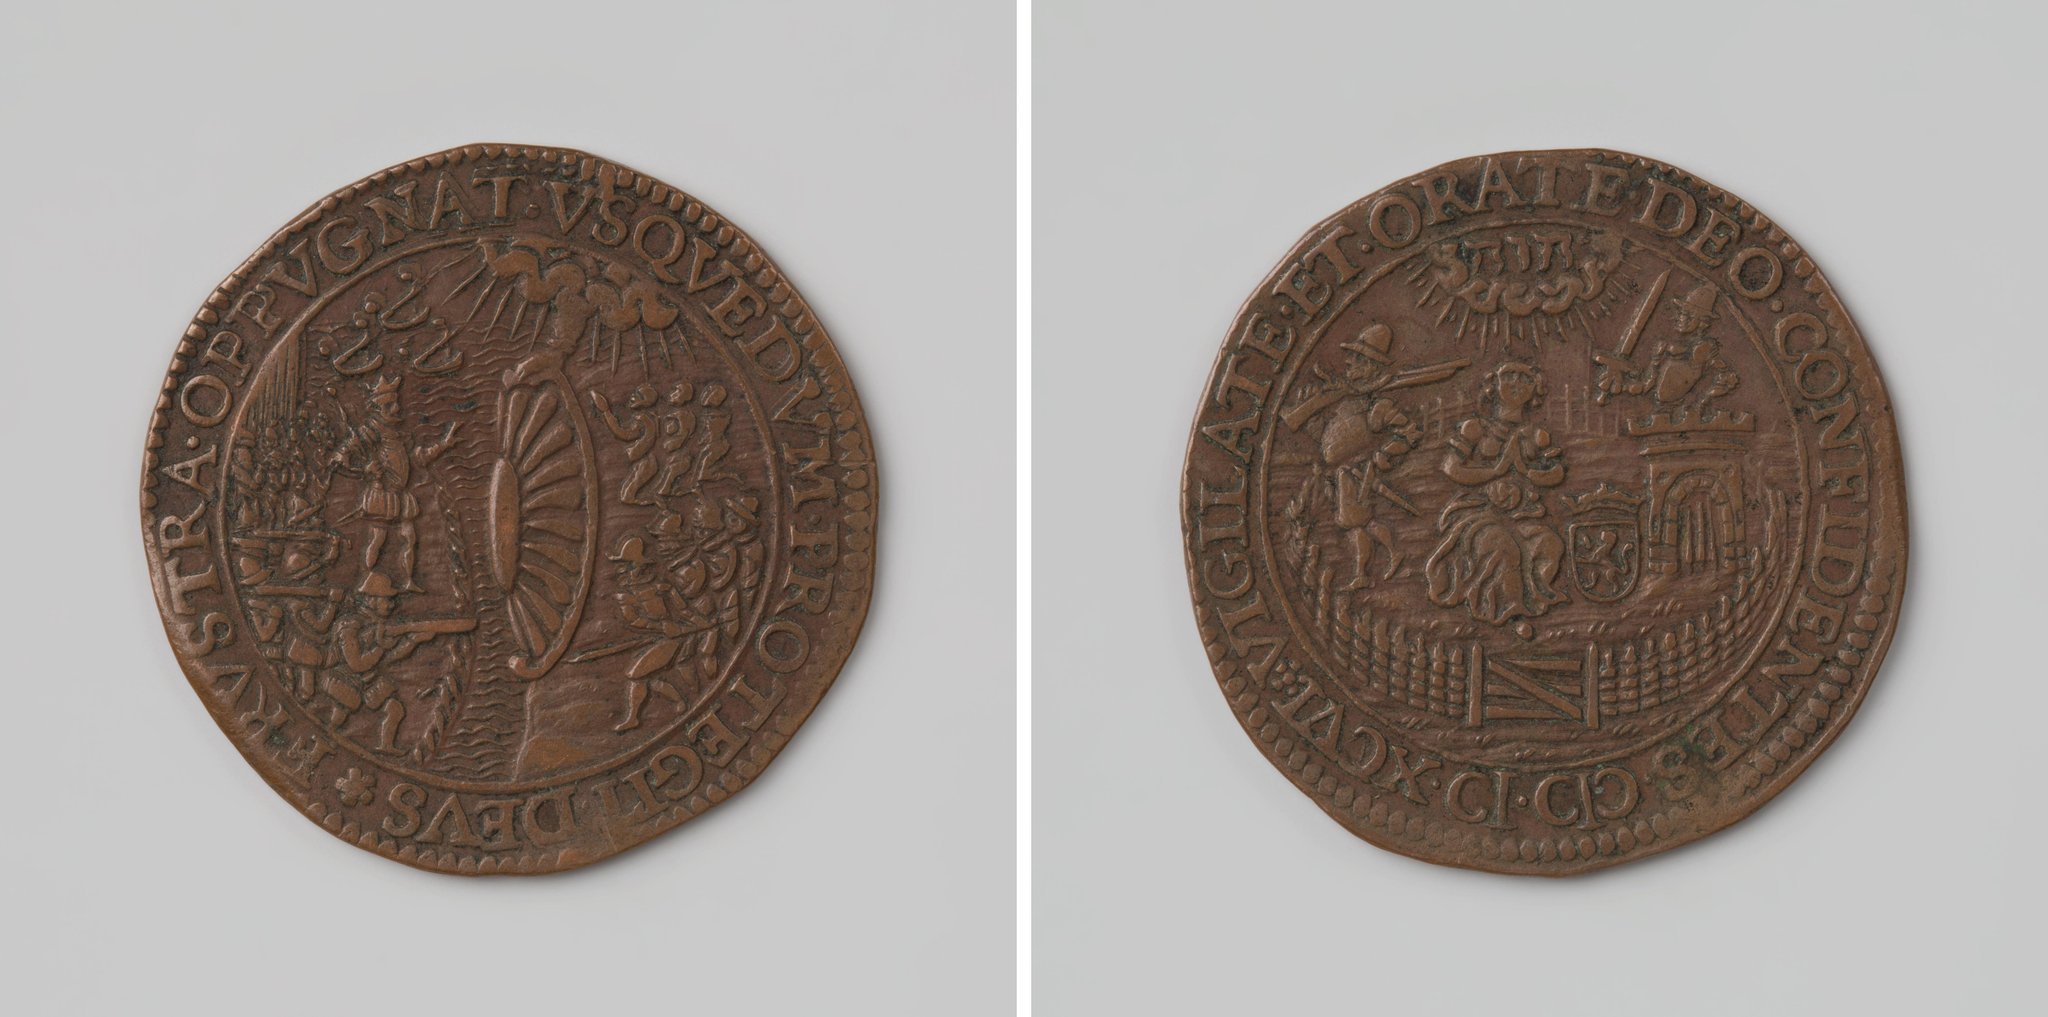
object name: jeton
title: Inval van Albrecht, aartshertog van Oostenrijk, in Zeeuws Vlaanderen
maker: Anonymous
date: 1596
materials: copper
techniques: striking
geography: dordrecht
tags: albrecht aartshertog van oostenrijk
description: Koperen penning. Voorzijde: Staatse leger en troepen onder leiding van de aartshertog van elkaar gescheiden door een schild, dat door hand uit wolken wordt vastgehouden binnen omschrift. Keerzijde: biddende Nederlandse maagd, zittend naast gekroond wapenschild in omheinde tuin; links: een soldaat met geweer over schouder, rechts: soldaat met getrokken zwaard, staande op toren binnen omschrift